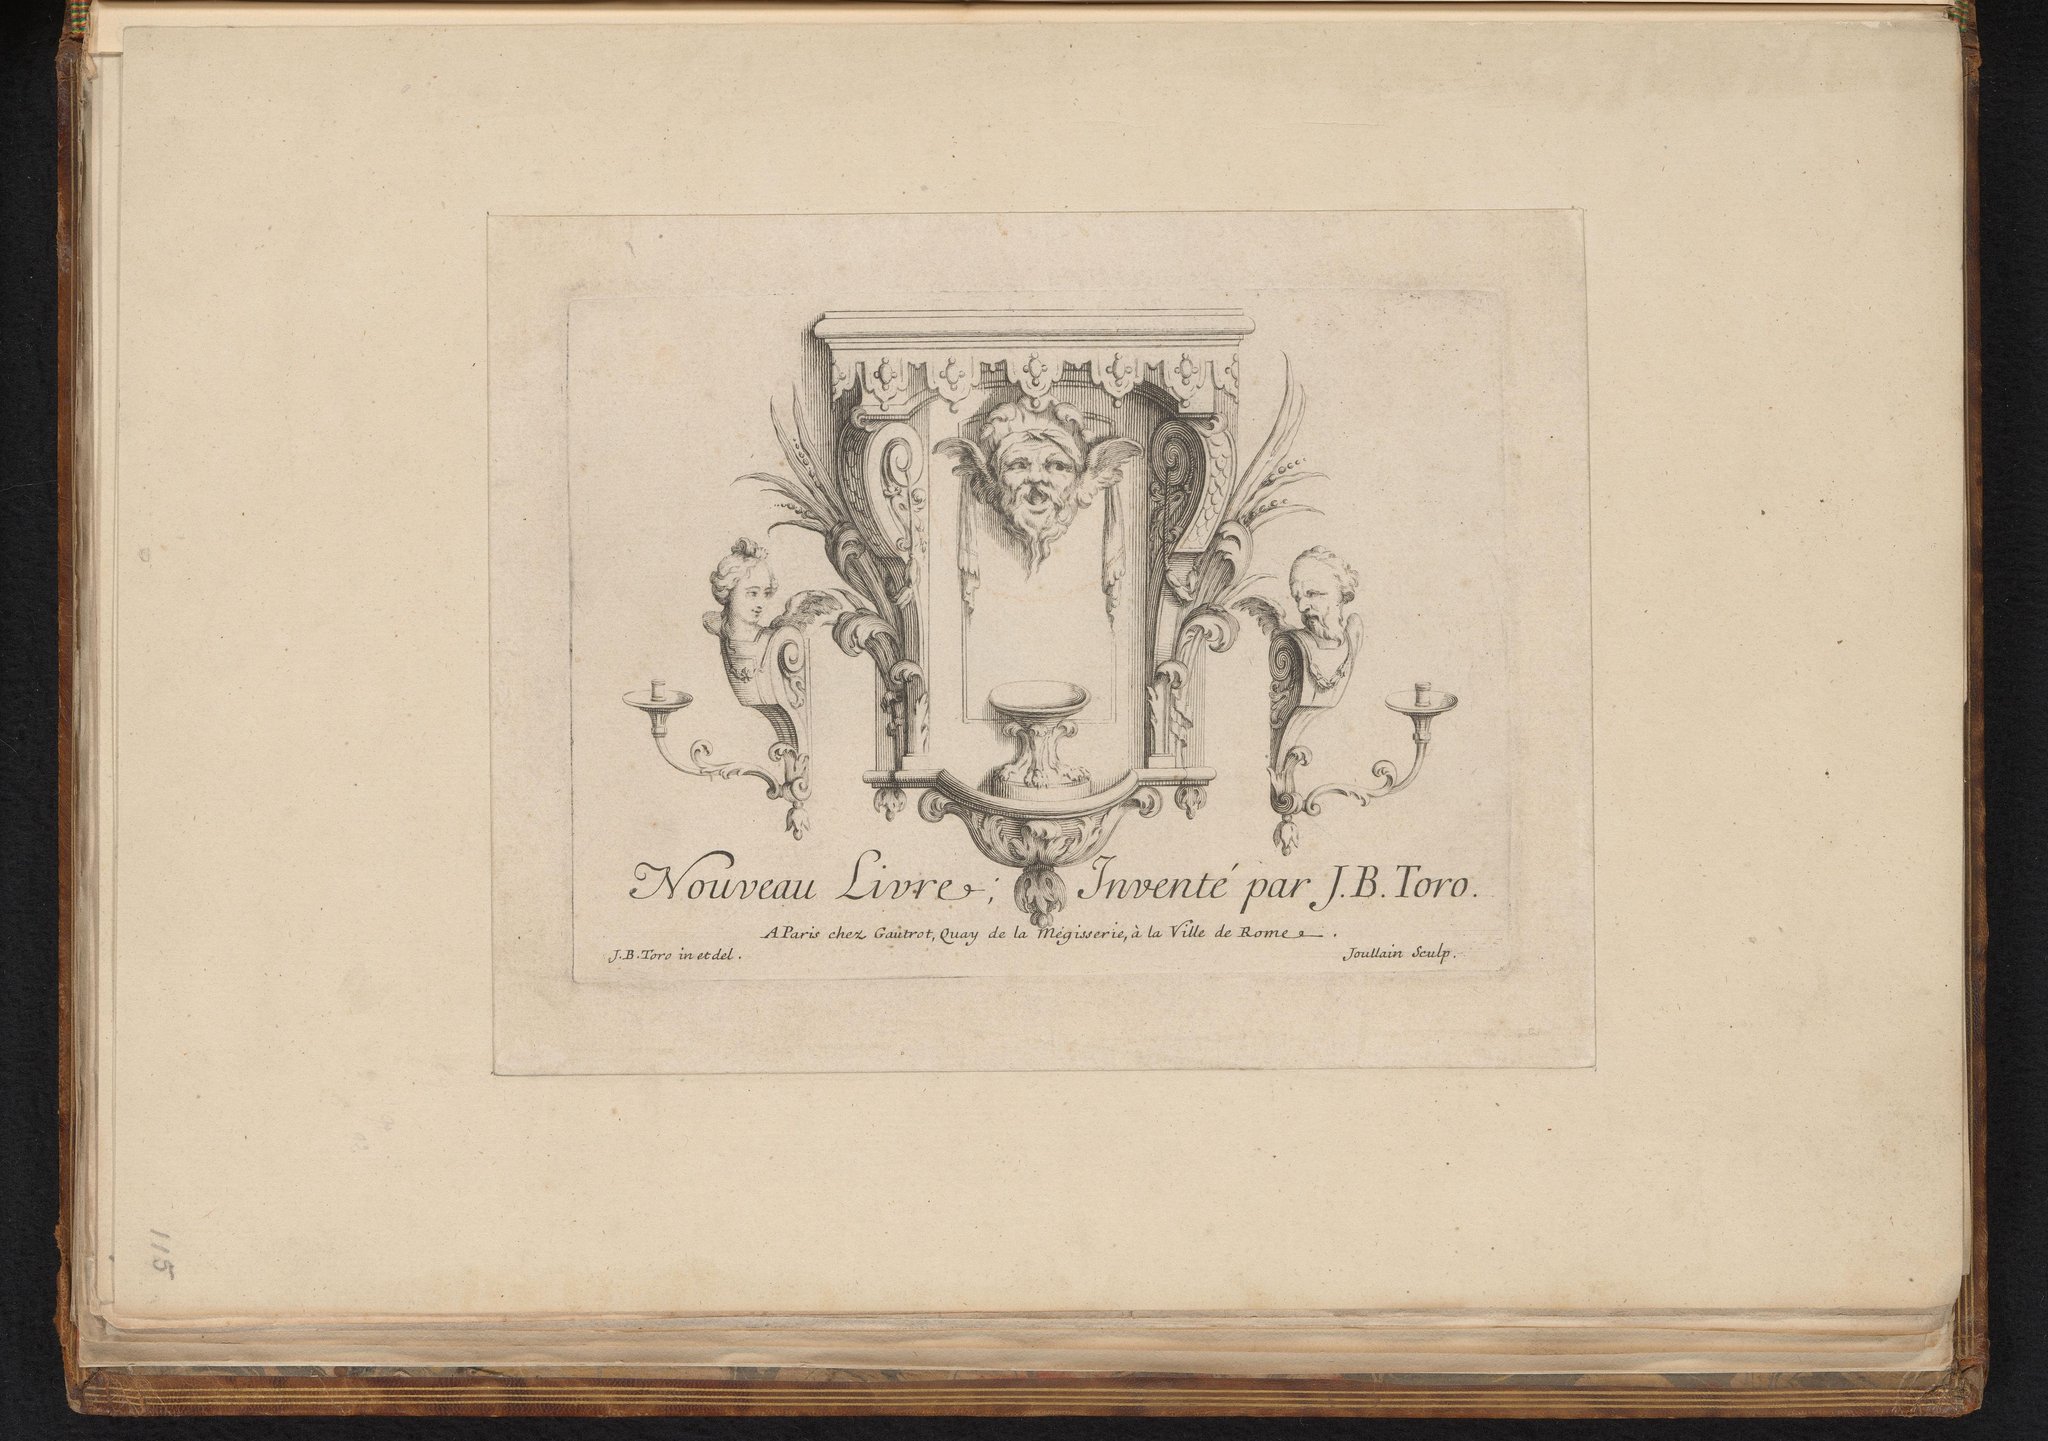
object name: titelprent, frontispice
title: Serie met diverse ornamenten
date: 1682-1739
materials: paper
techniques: etching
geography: paris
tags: mask, mascaron ~ ornament, foliage, tendrils, branches ~ ornament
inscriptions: collector's mark: Lugt 2228, collector's mark: Lugt 2760